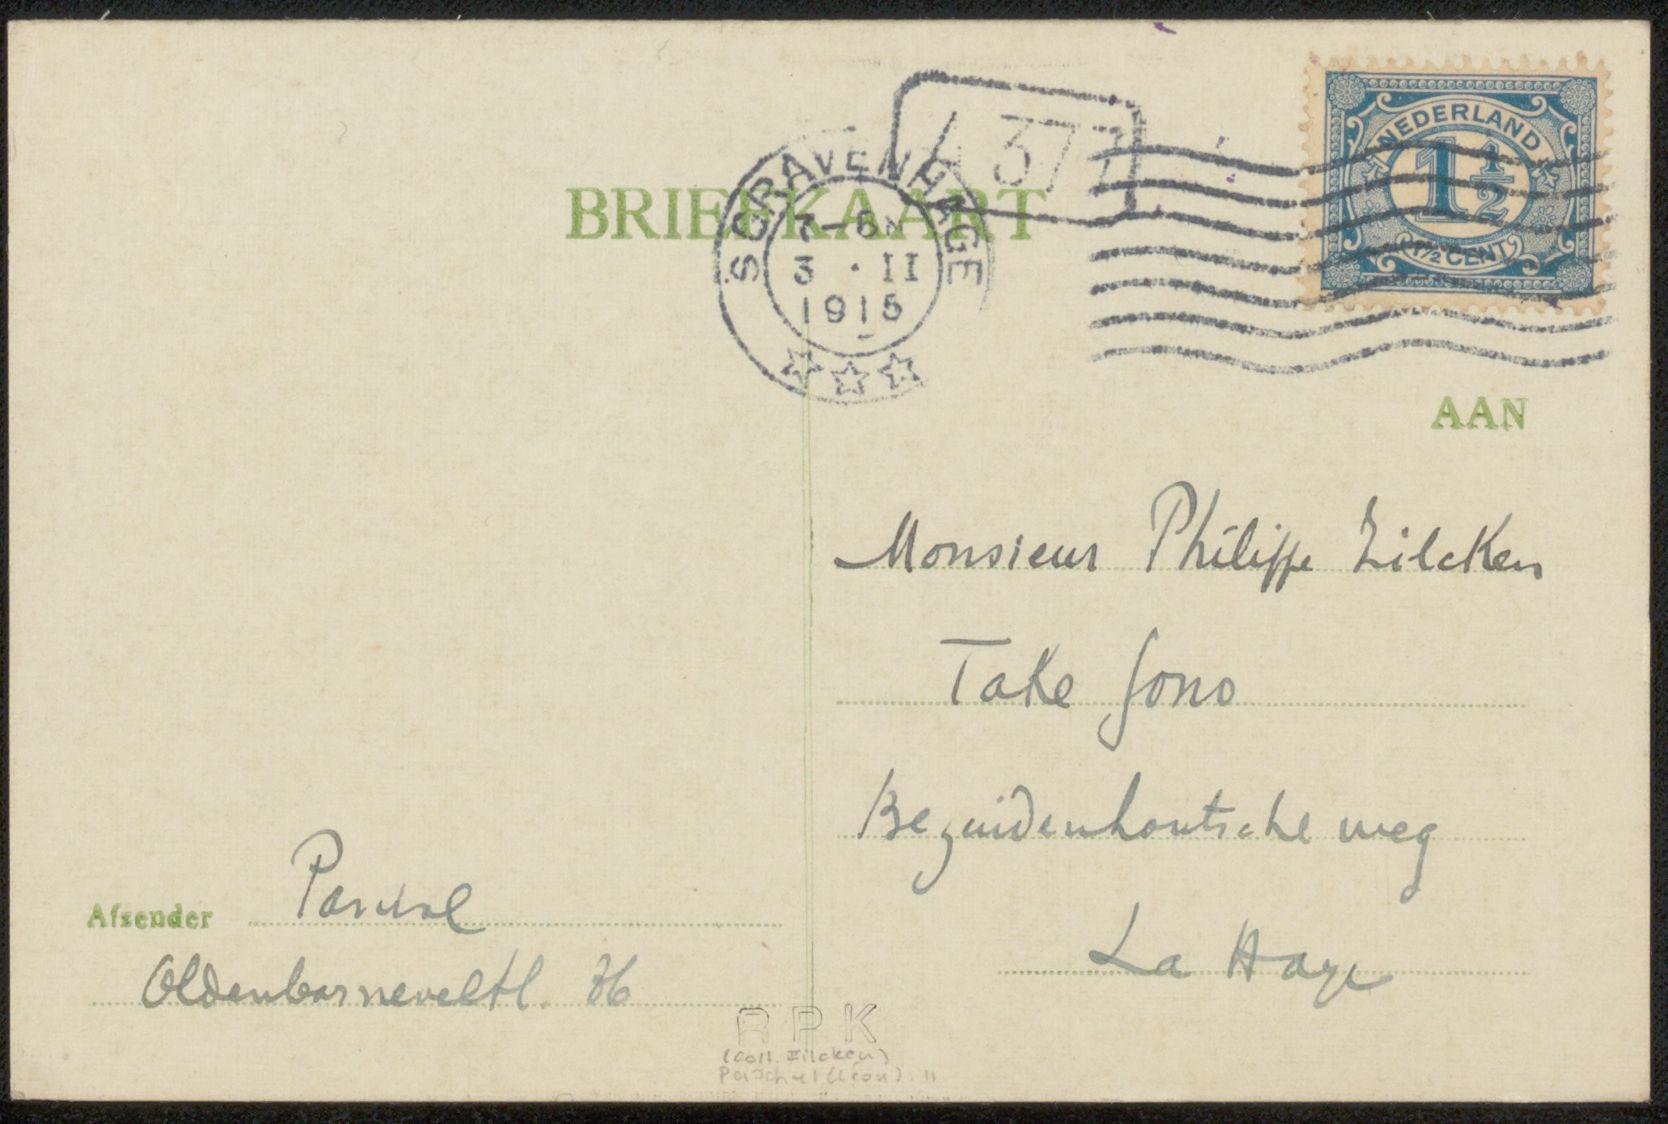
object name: postcard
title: Briefkaart aan Philip Zilcken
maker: léon paschal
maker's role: schrijver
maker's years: 1873-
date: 1915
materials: cardboard, ink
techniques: pen, writing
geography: the hague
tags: the hague, painter, draughtsman, philip zilcken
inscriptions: collector's mark: ‘RPK’